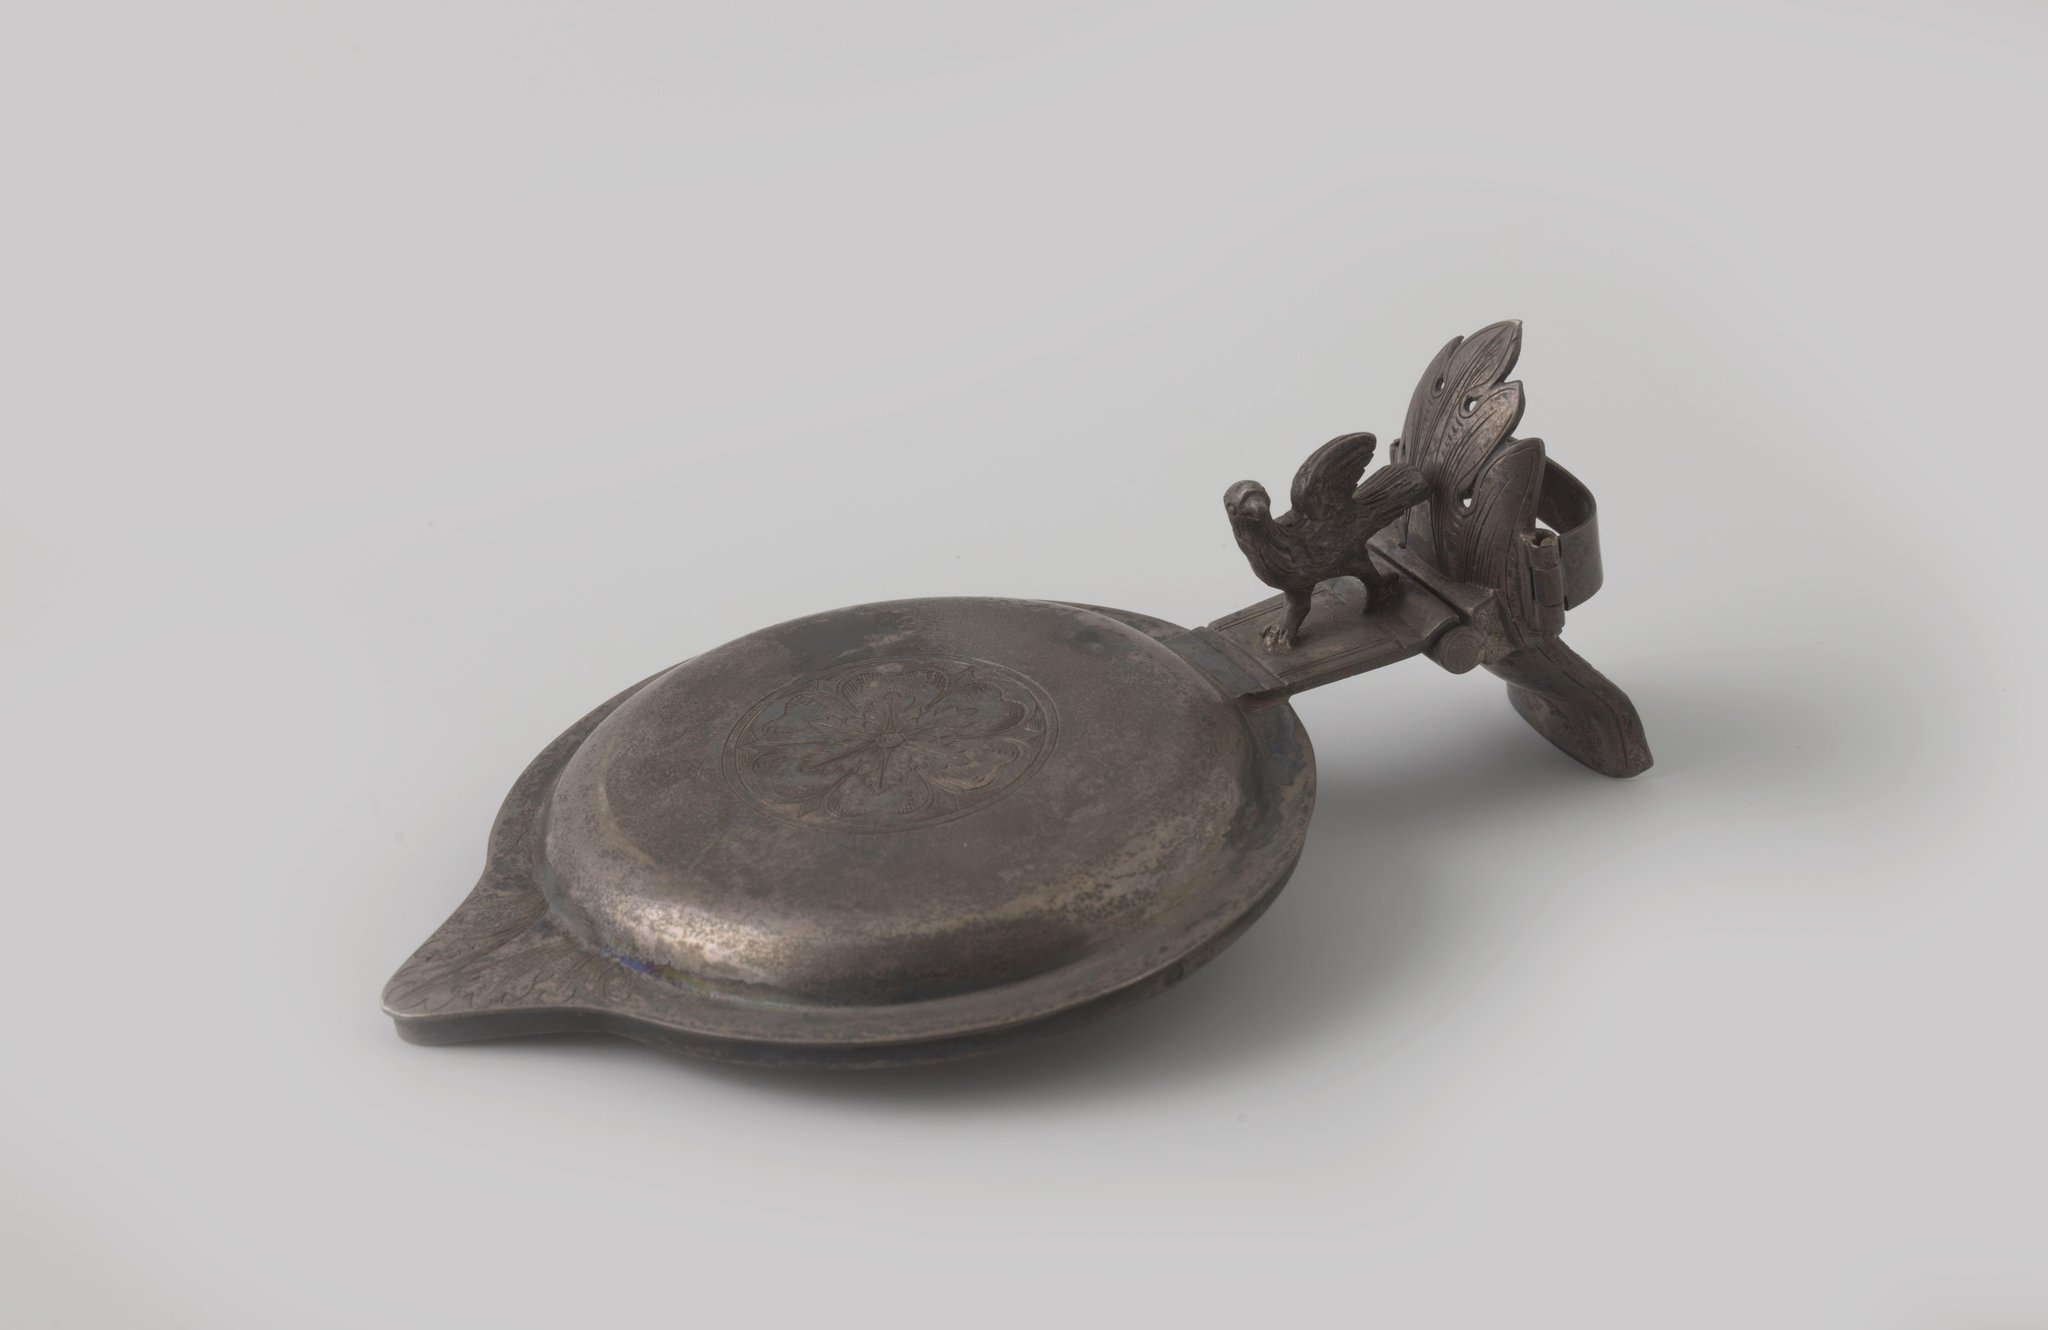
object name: ewer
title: Deksel van zilver, behorend bij een kan van faience.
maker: Anonymous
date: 1750-1770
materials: silver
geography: delft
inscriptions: mark: ‘wapen van Amsterdam’, mark: ‘klimmende leeuw’, mark: ‘S.I. of I.S. (meesterteken)’, mark: ‘Z (jaarletter)’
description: Deksel van zilver, behorend bij een kan van faience. Het deksel is aan de bovenzijde gegraveerd met een rozet.